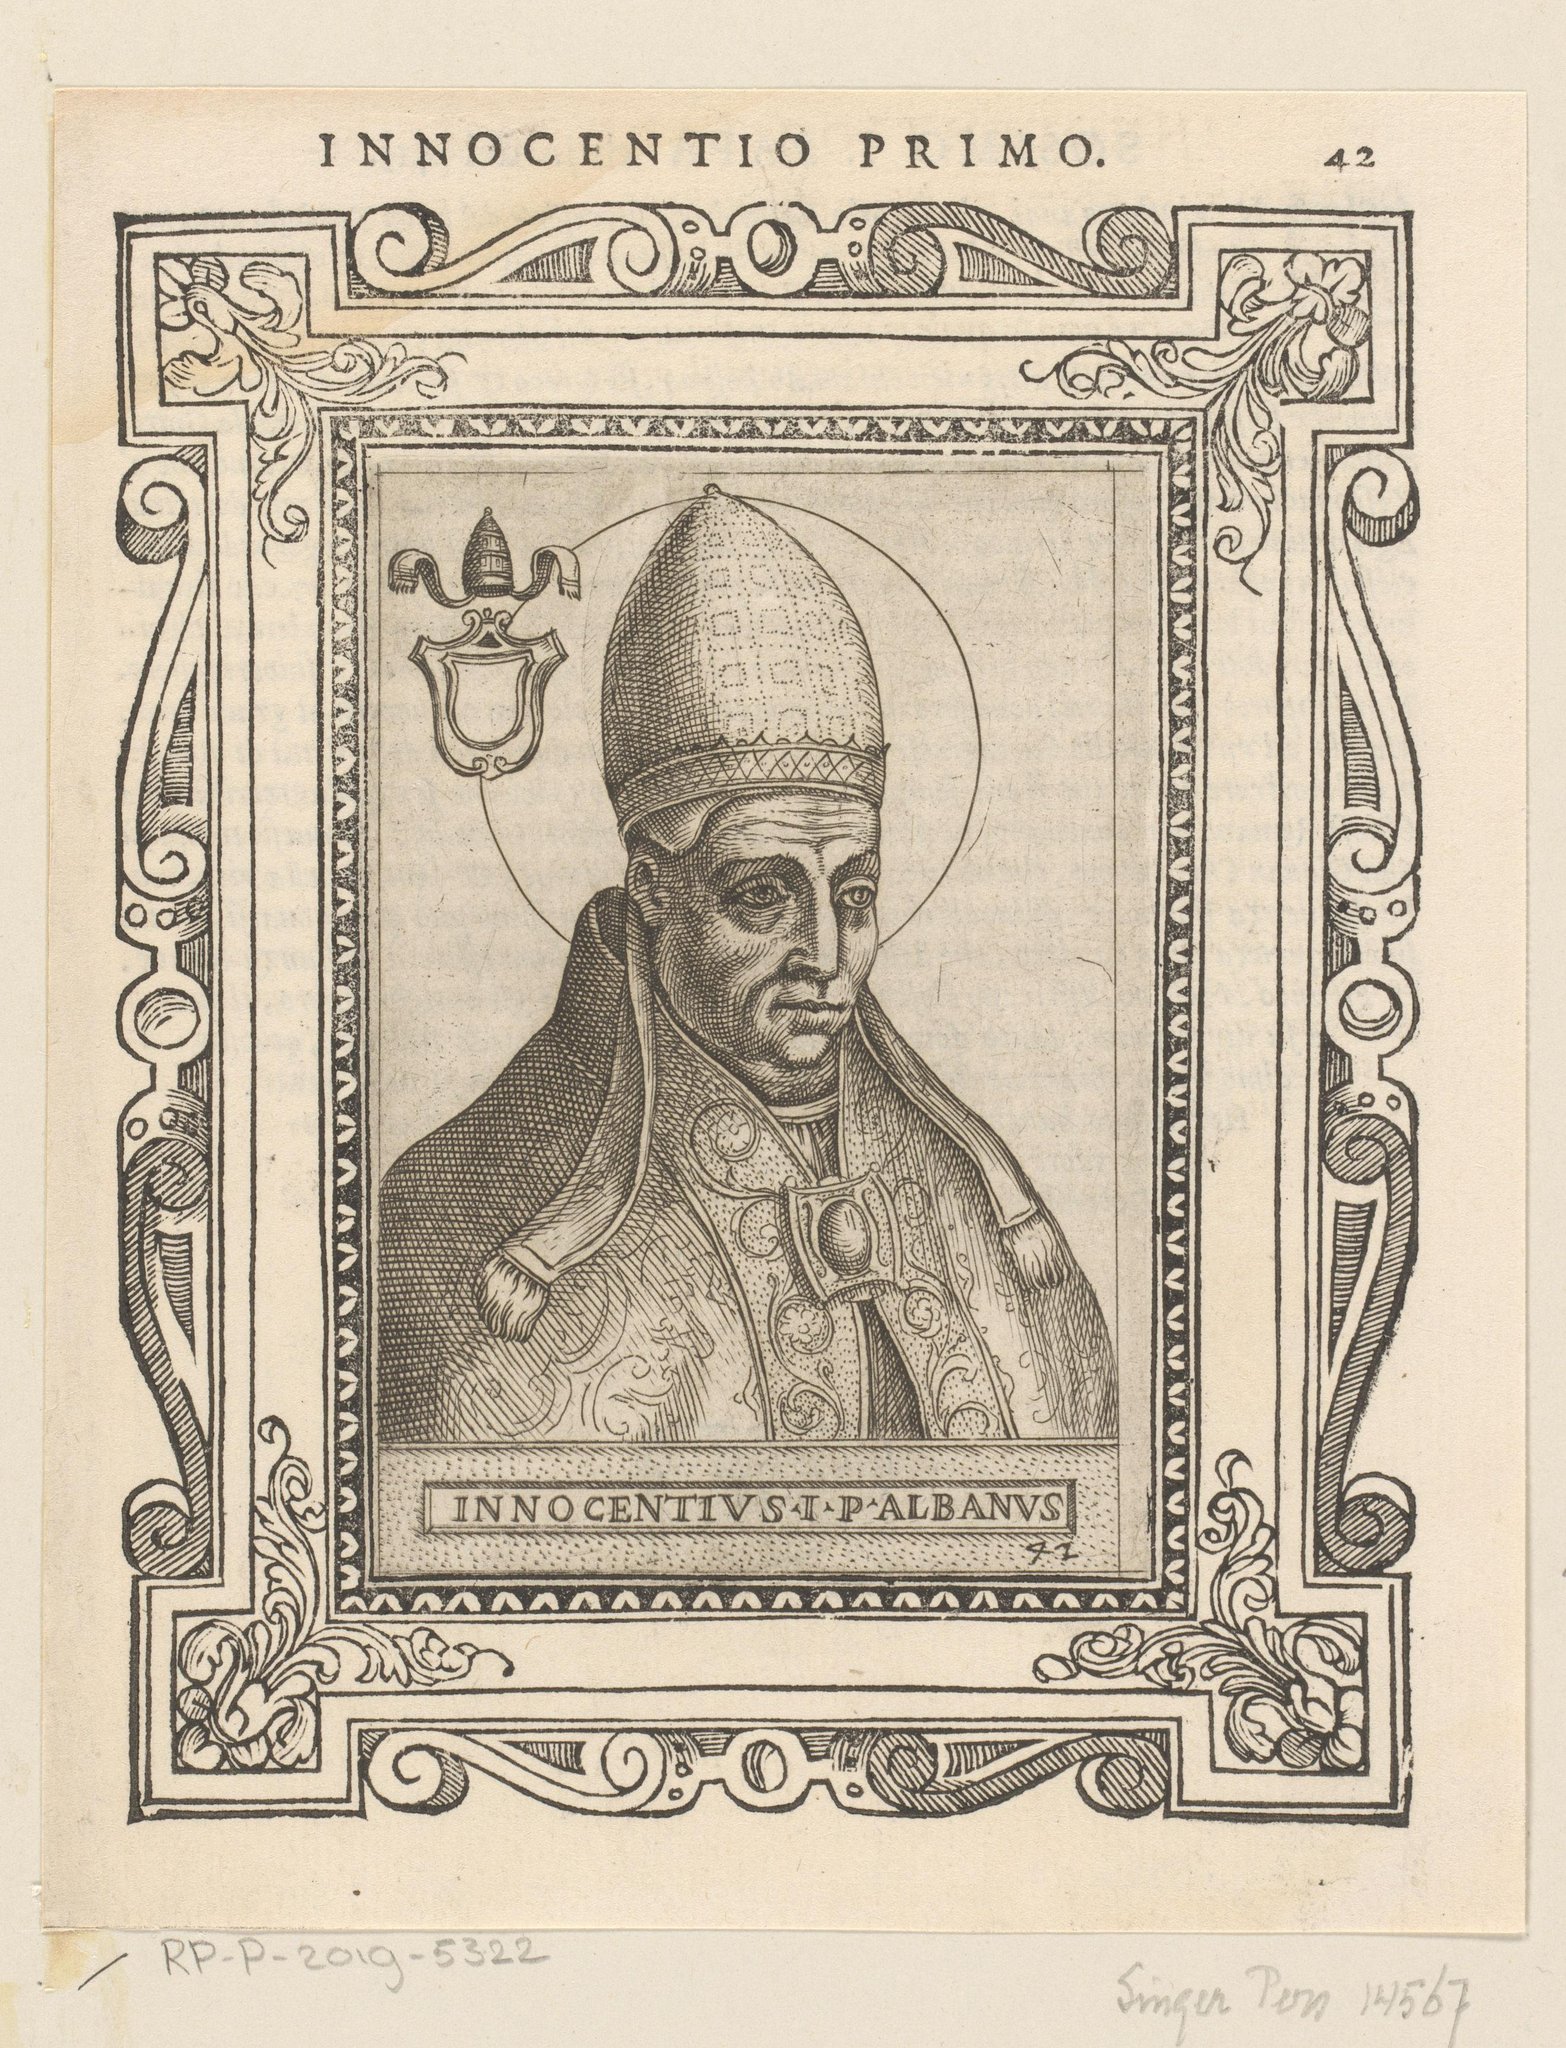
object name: book illustration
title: Portret van paus Innocentius I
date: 1587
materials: paper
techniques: engraving, letterpress printing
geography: rome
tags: historical persons, pope, armorial bearing, heraldry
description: Prent uit: Ciccarelli, Antonio. Le vite de Pontefici di Antonio Ciccarelli (...). Rome: Domenico Basa, 1587. Prent voor het eerst verschenen in: Cavalieri, Giovanni Battista de'. Pontificum romanorum effigies (...). Rome: Domenico Basa en Francesco Zanetti, 1580. Prent ook gebruikt in latere publicaties.